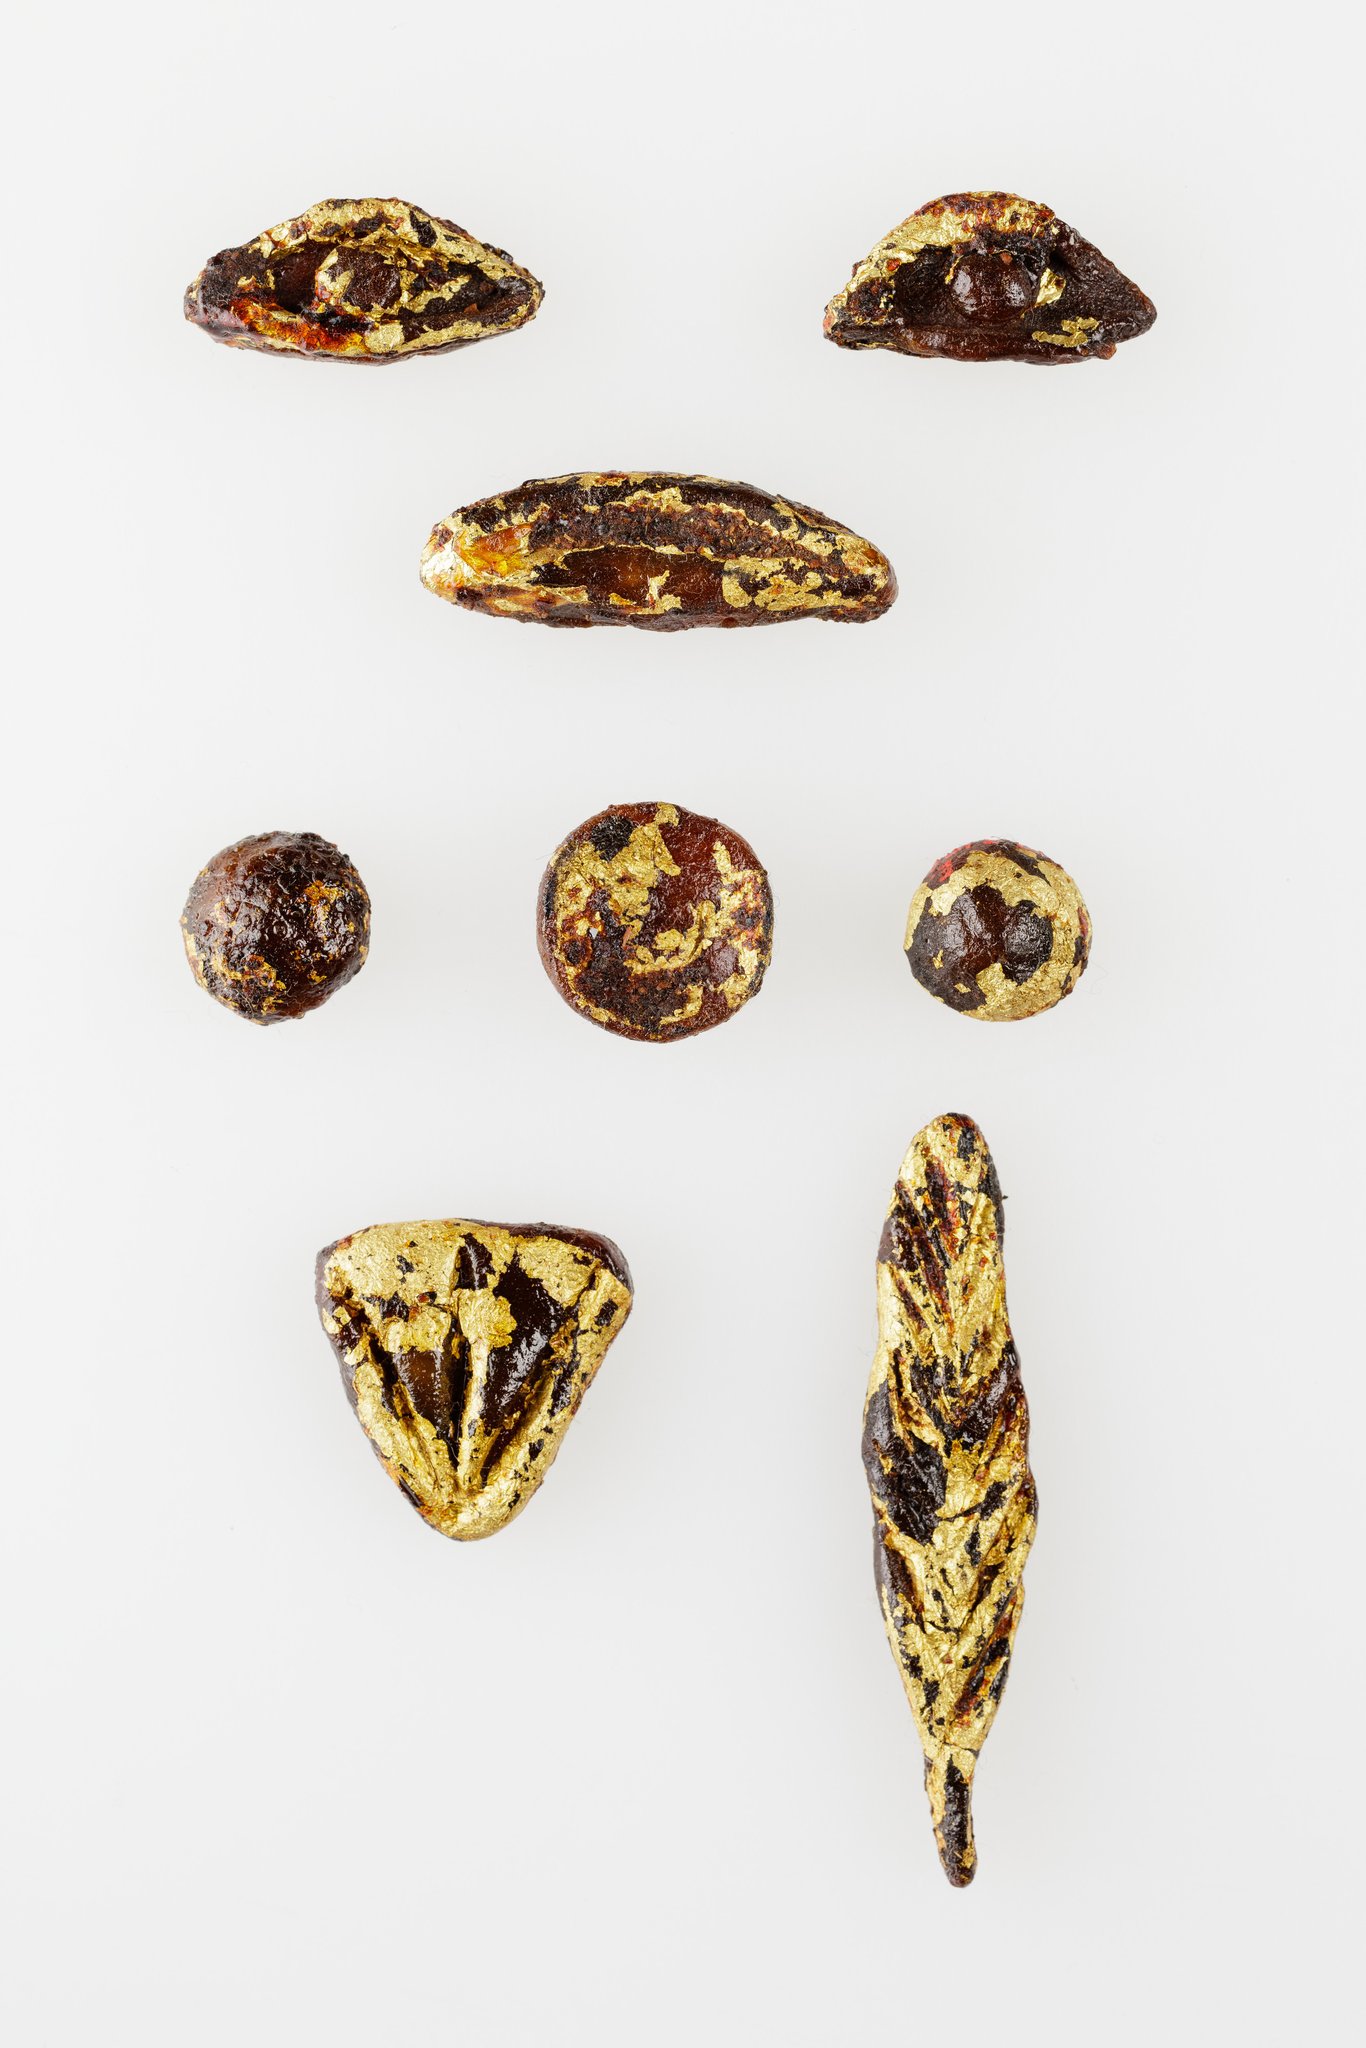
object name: amulet 8, wax dish, body part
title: Set of Amulets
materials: gold leaf, wax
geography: egypt